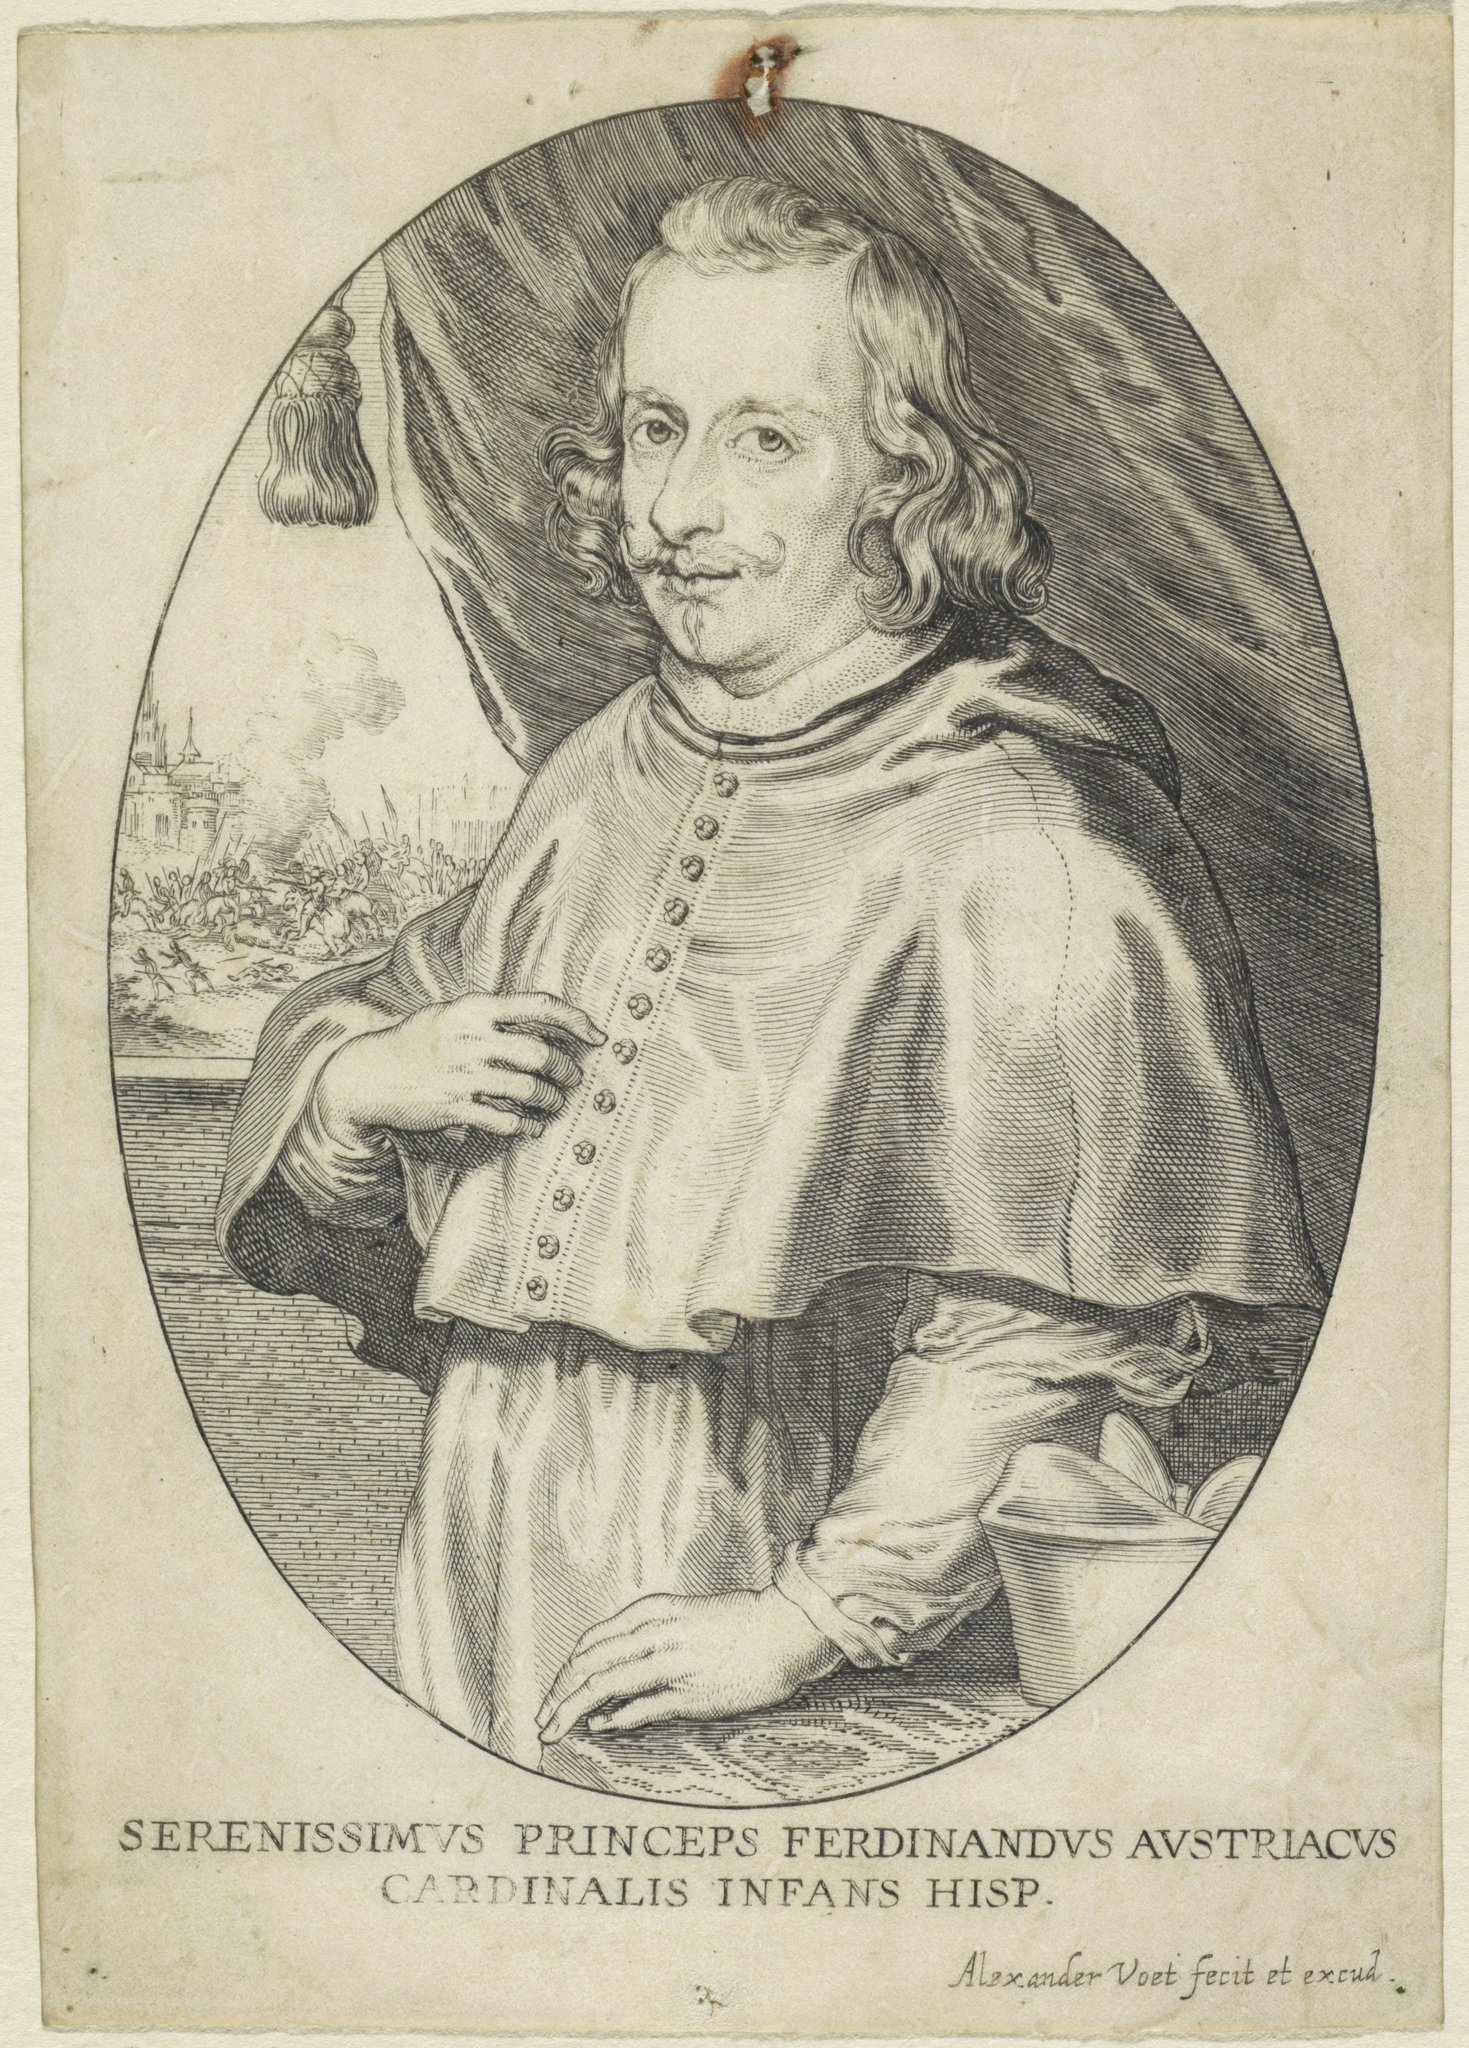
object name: print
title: Ferdinand van Oostenrijk, landvoogd der zuidelijke Nederlanden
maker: alexander voet (i)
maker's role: print maker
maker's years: 1613-1690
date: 1634-1641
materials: parchment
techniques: engraving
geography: antwerp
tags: landvoogd der zuidelijke nederlanden ferdinand van oostenrijk, insignia of cardinal, e.g. hat, mantle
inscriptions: collector's mark: Lugt 2228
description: Ferdinand van Oostenrijk, als kardinaal-infant van Spanje.